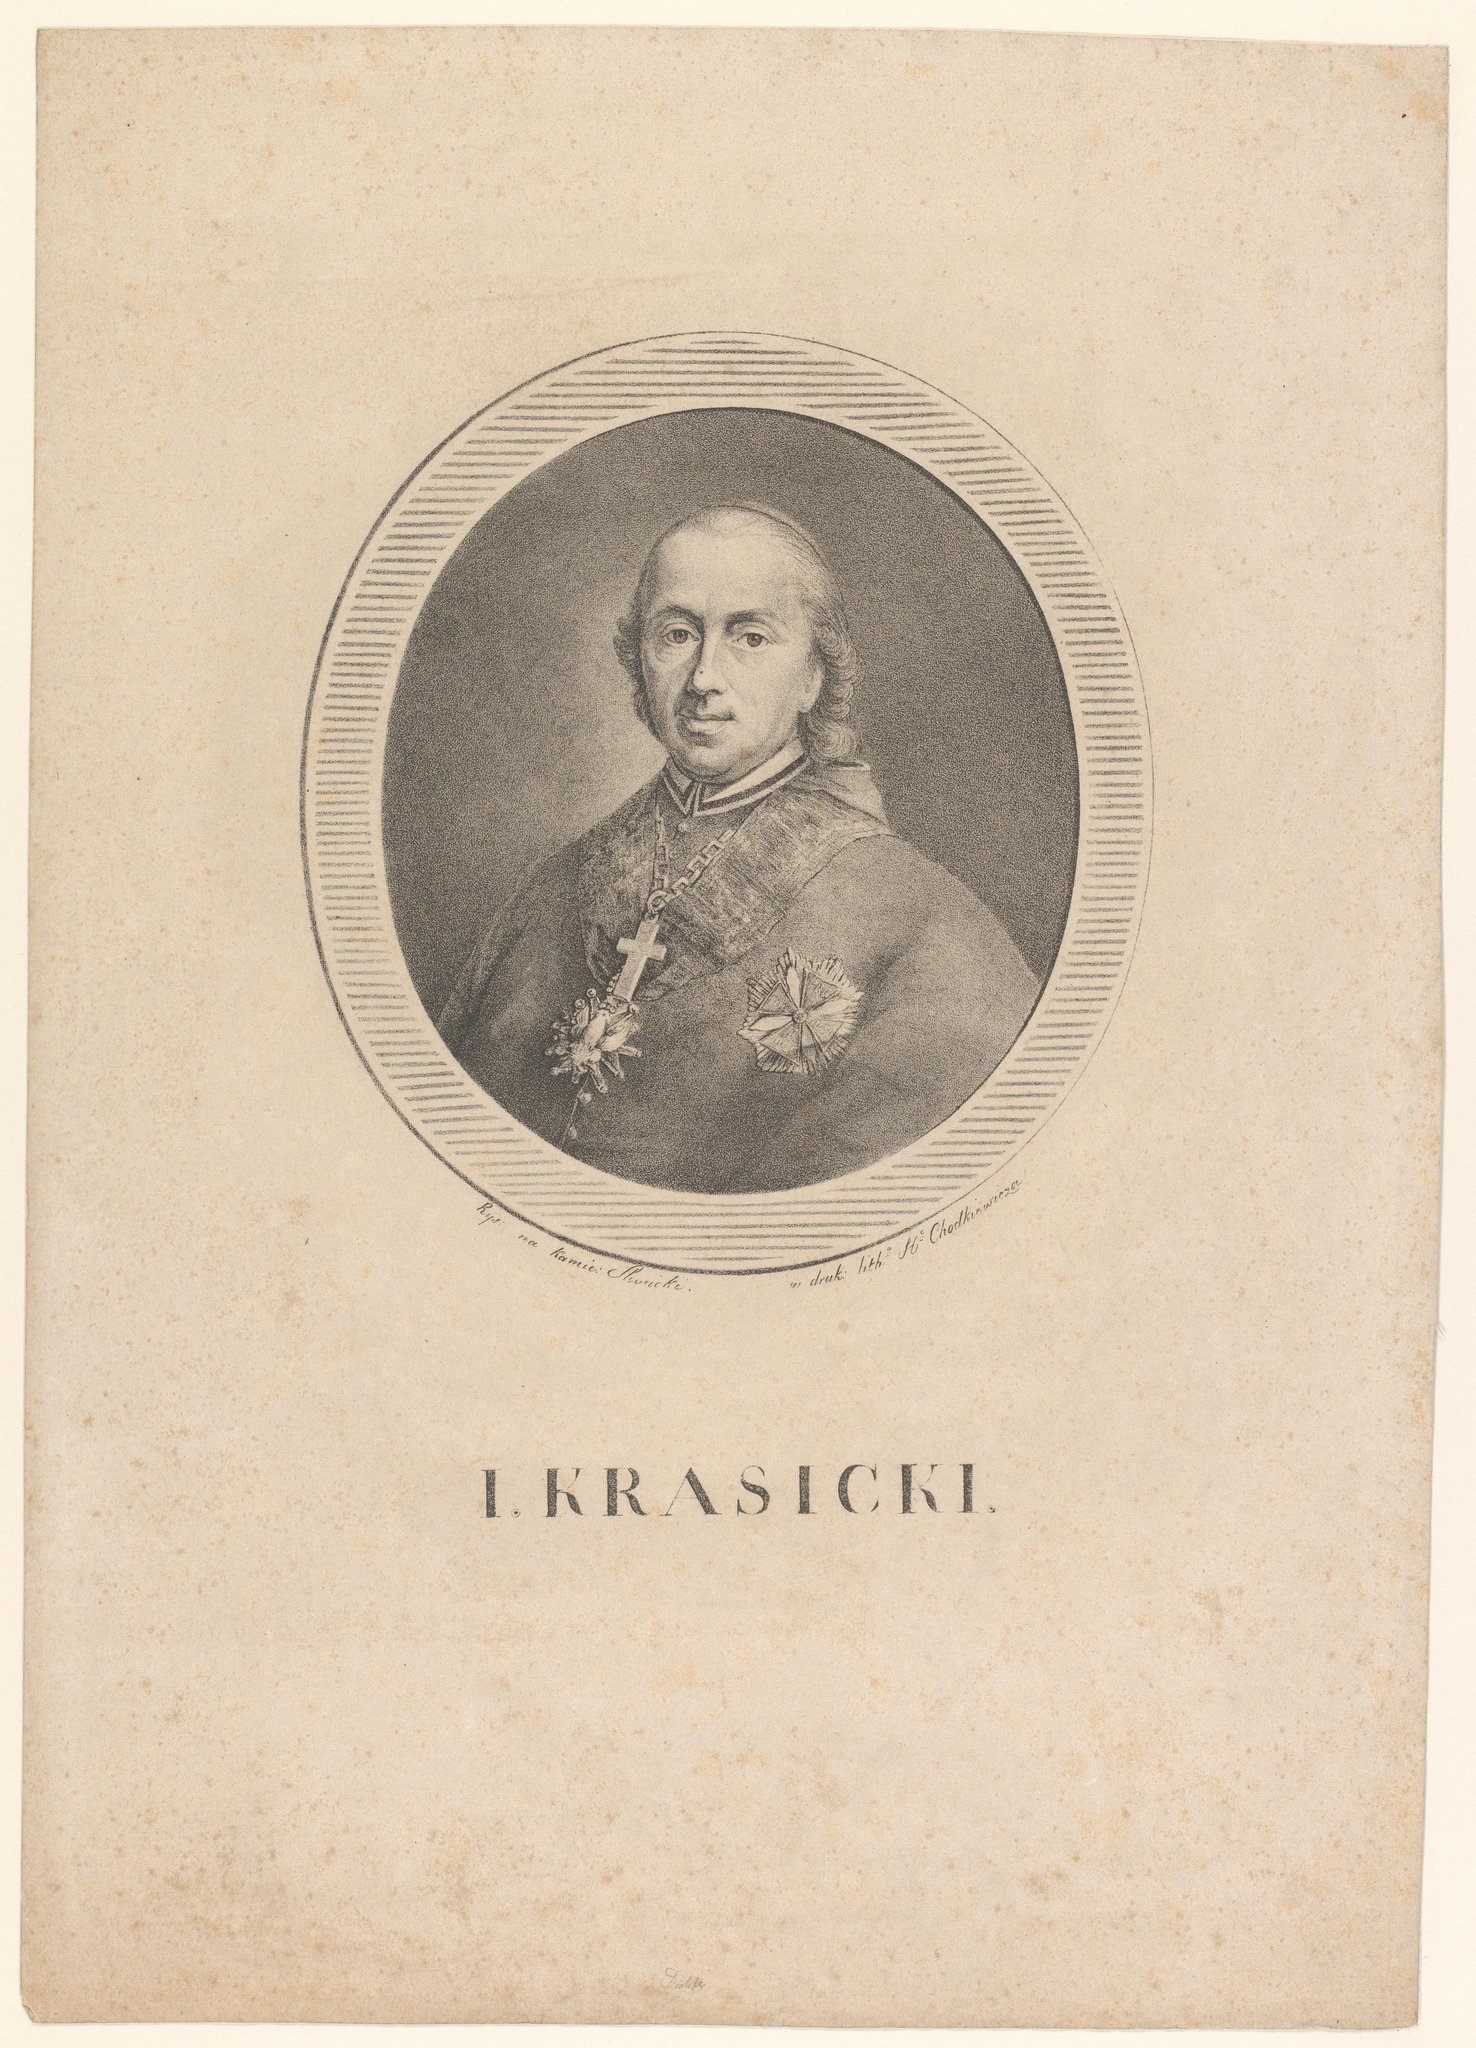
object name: print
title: I. Krasicki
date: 1810-1857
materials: paper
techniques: lithograph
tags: adult man, historical persons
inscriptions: collector's mark: Lugt 2228